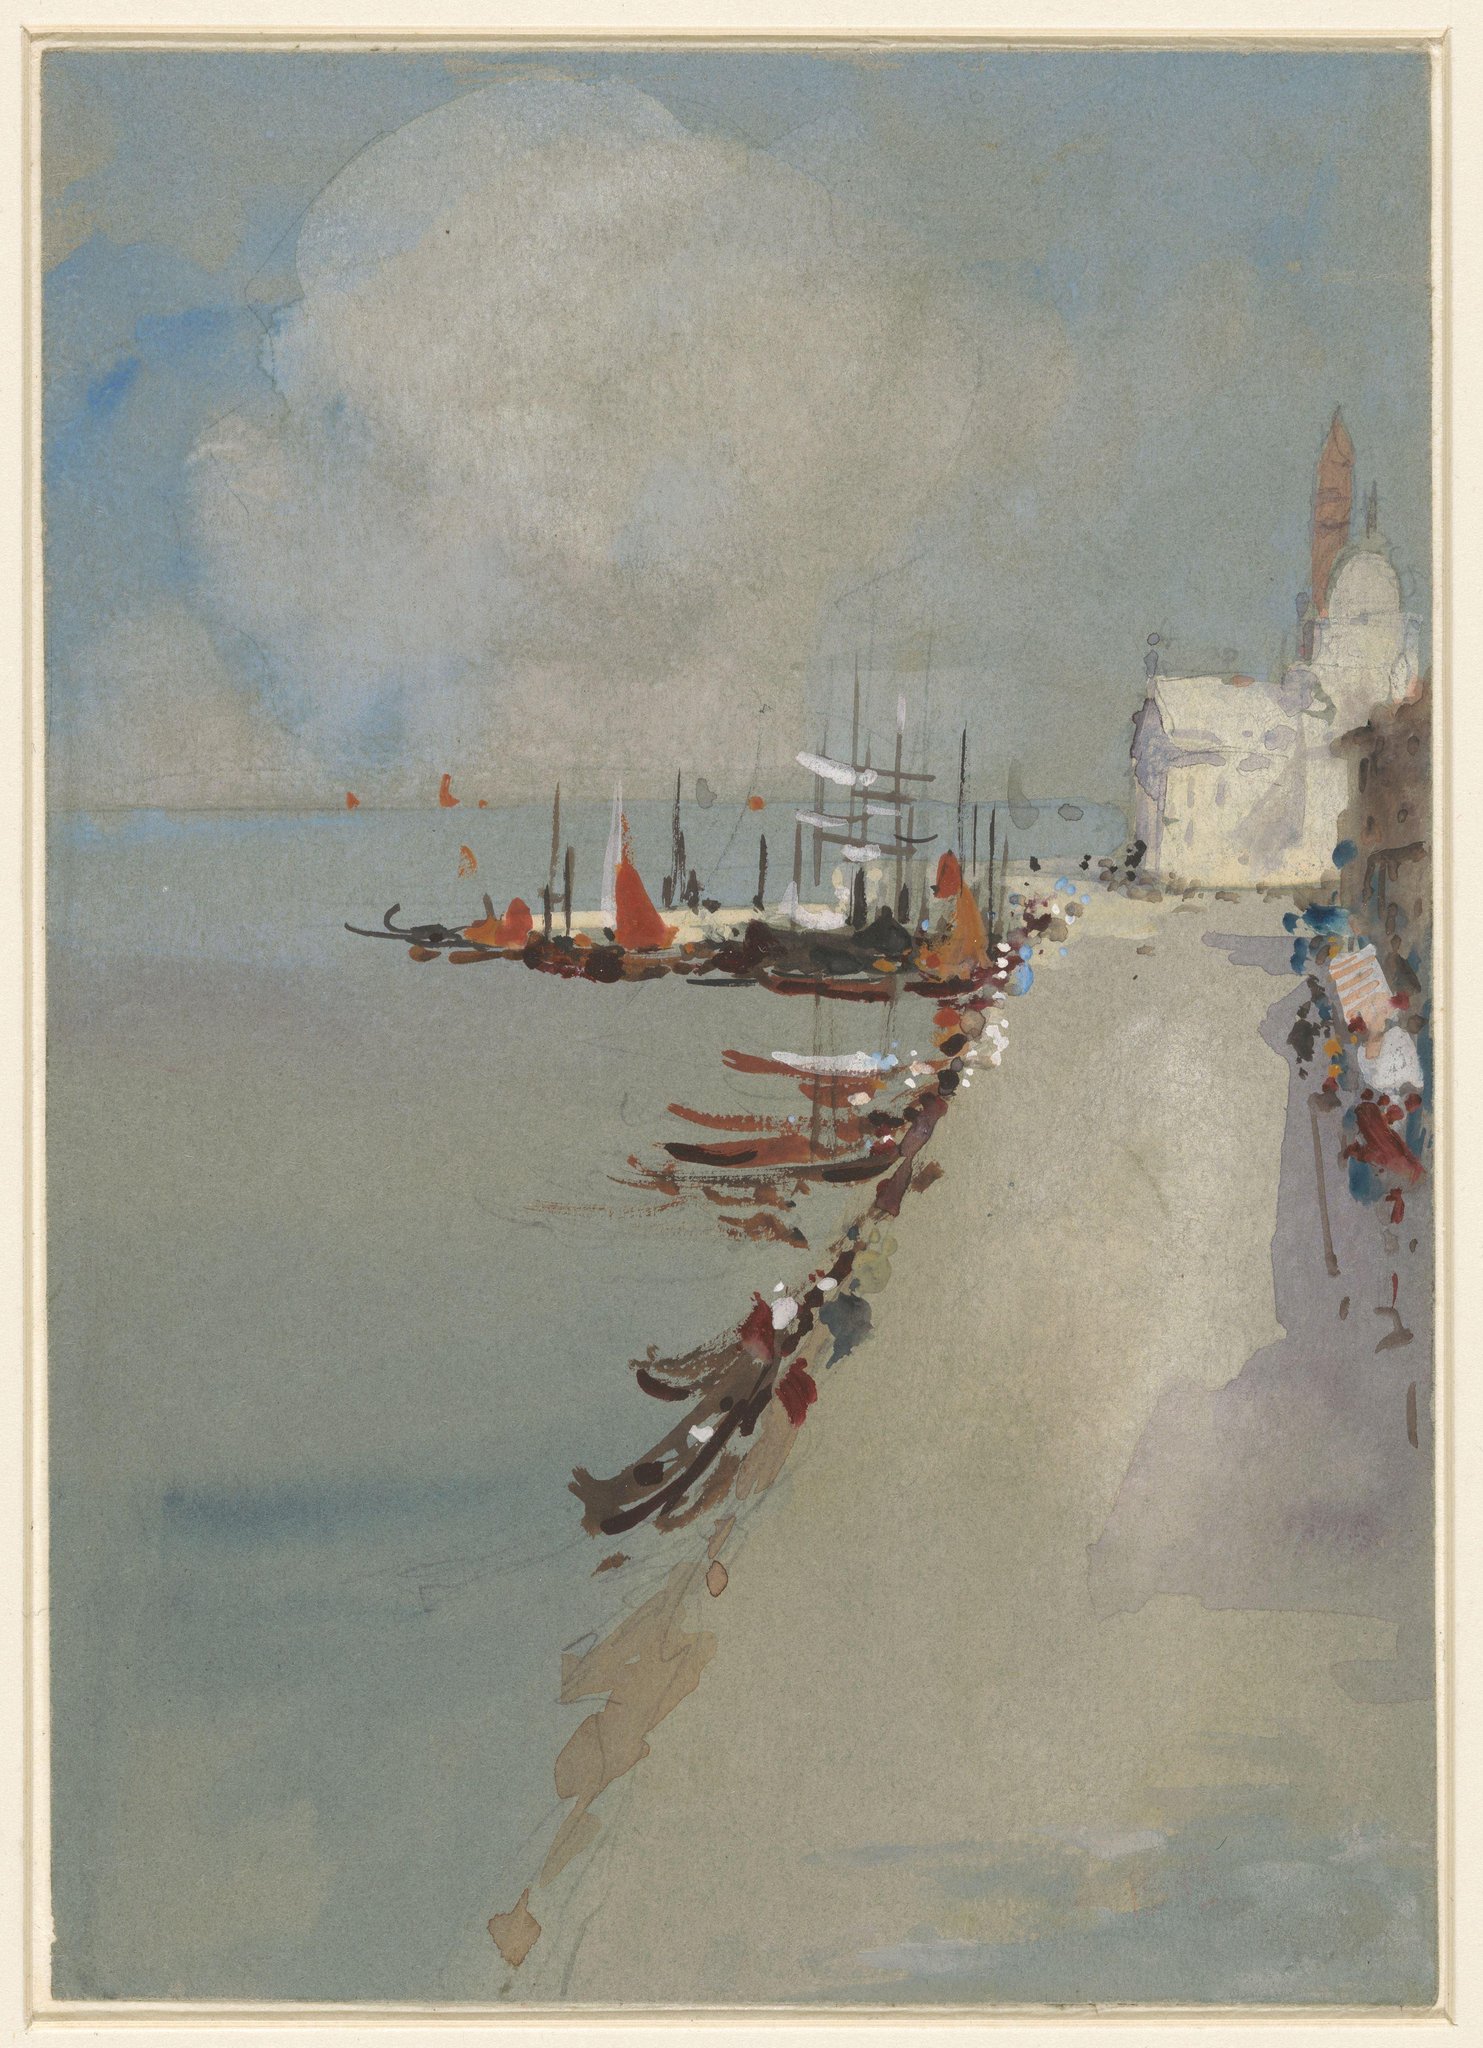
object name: watercolor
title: Gezicht te Venetië met het kanaal van Giudecca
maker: hercules brabazon brabazon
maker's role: draughtsman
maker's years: 1821-1906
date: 1831-1906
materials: paper, pencil, watercolor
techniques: brush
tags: public road (+ city(-scape) with figures, staffage), canals, waters (in city) (+ city(-scape) with figures, staffage)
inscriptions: inscription: ‘Guidecca Canal Venice’